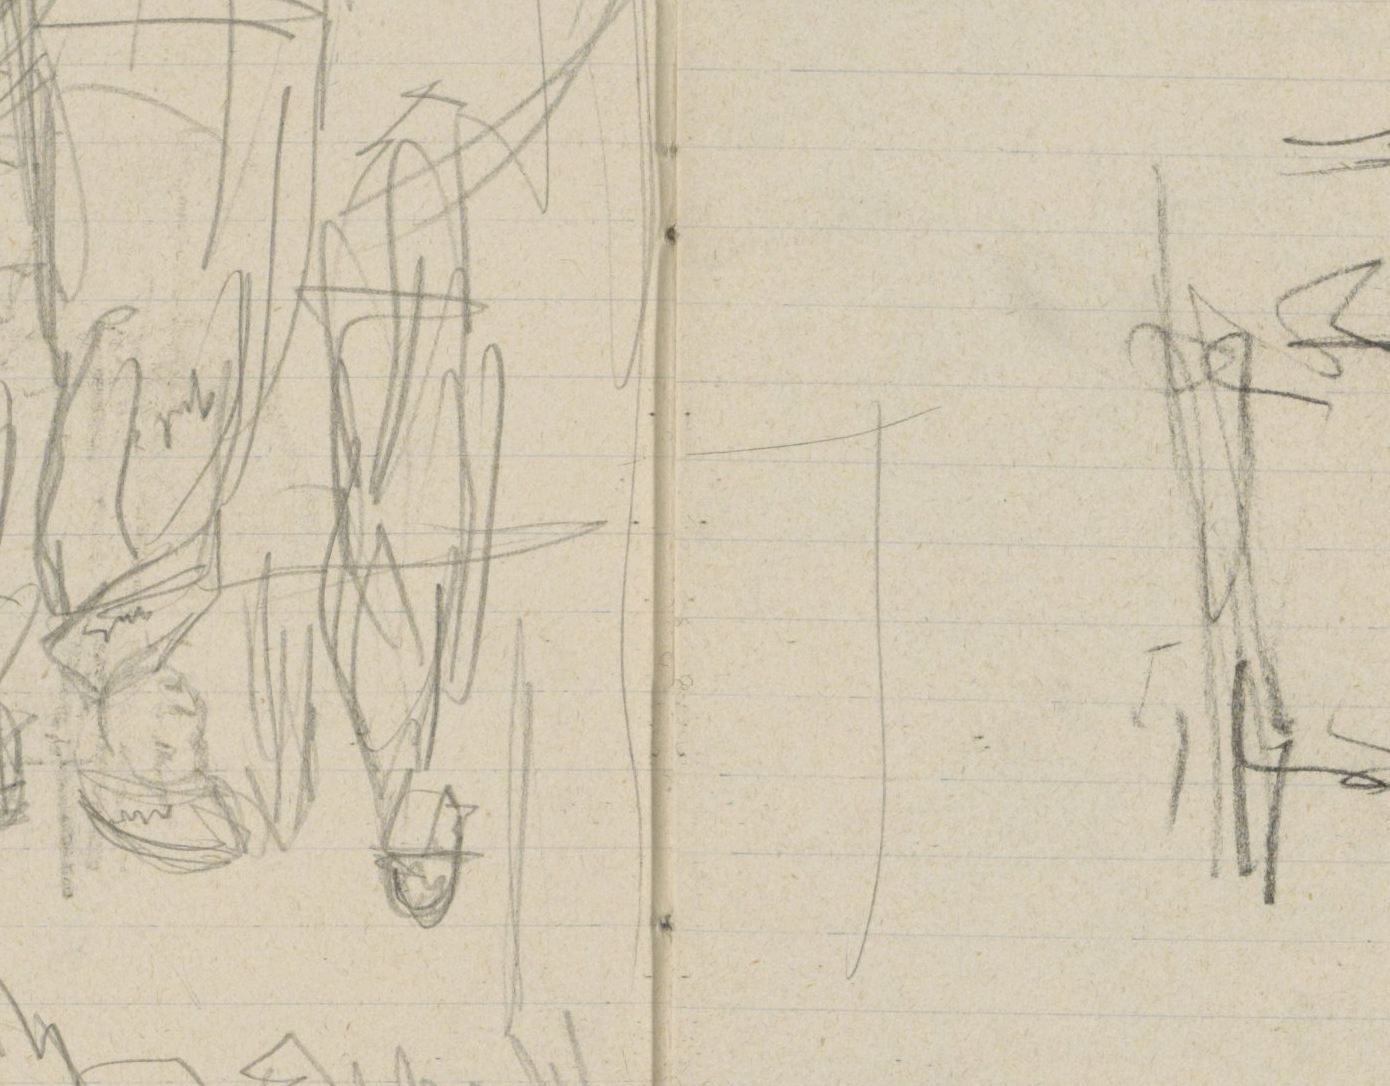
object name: sketchbook leaf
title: Twee gezichten in Amsterdam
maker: george hendrik breitner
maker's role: draughtsman, painter, print maker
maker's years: 1857-1923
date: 1903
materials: chalk, pencil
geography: amsterdam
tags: adult woman, adult man, civic architecture; edifices; dwellings, street (+ city(-scape) with figures, staffage)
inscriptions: annotation: ‘[...]/ avond/ hoek Hirsch[?]’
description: De figuren staan mogelijk voor Hirsch & Cie aan het Leidseplein. Pagina 51 en pagina 52 uit een schetsboek met 32 bladen.